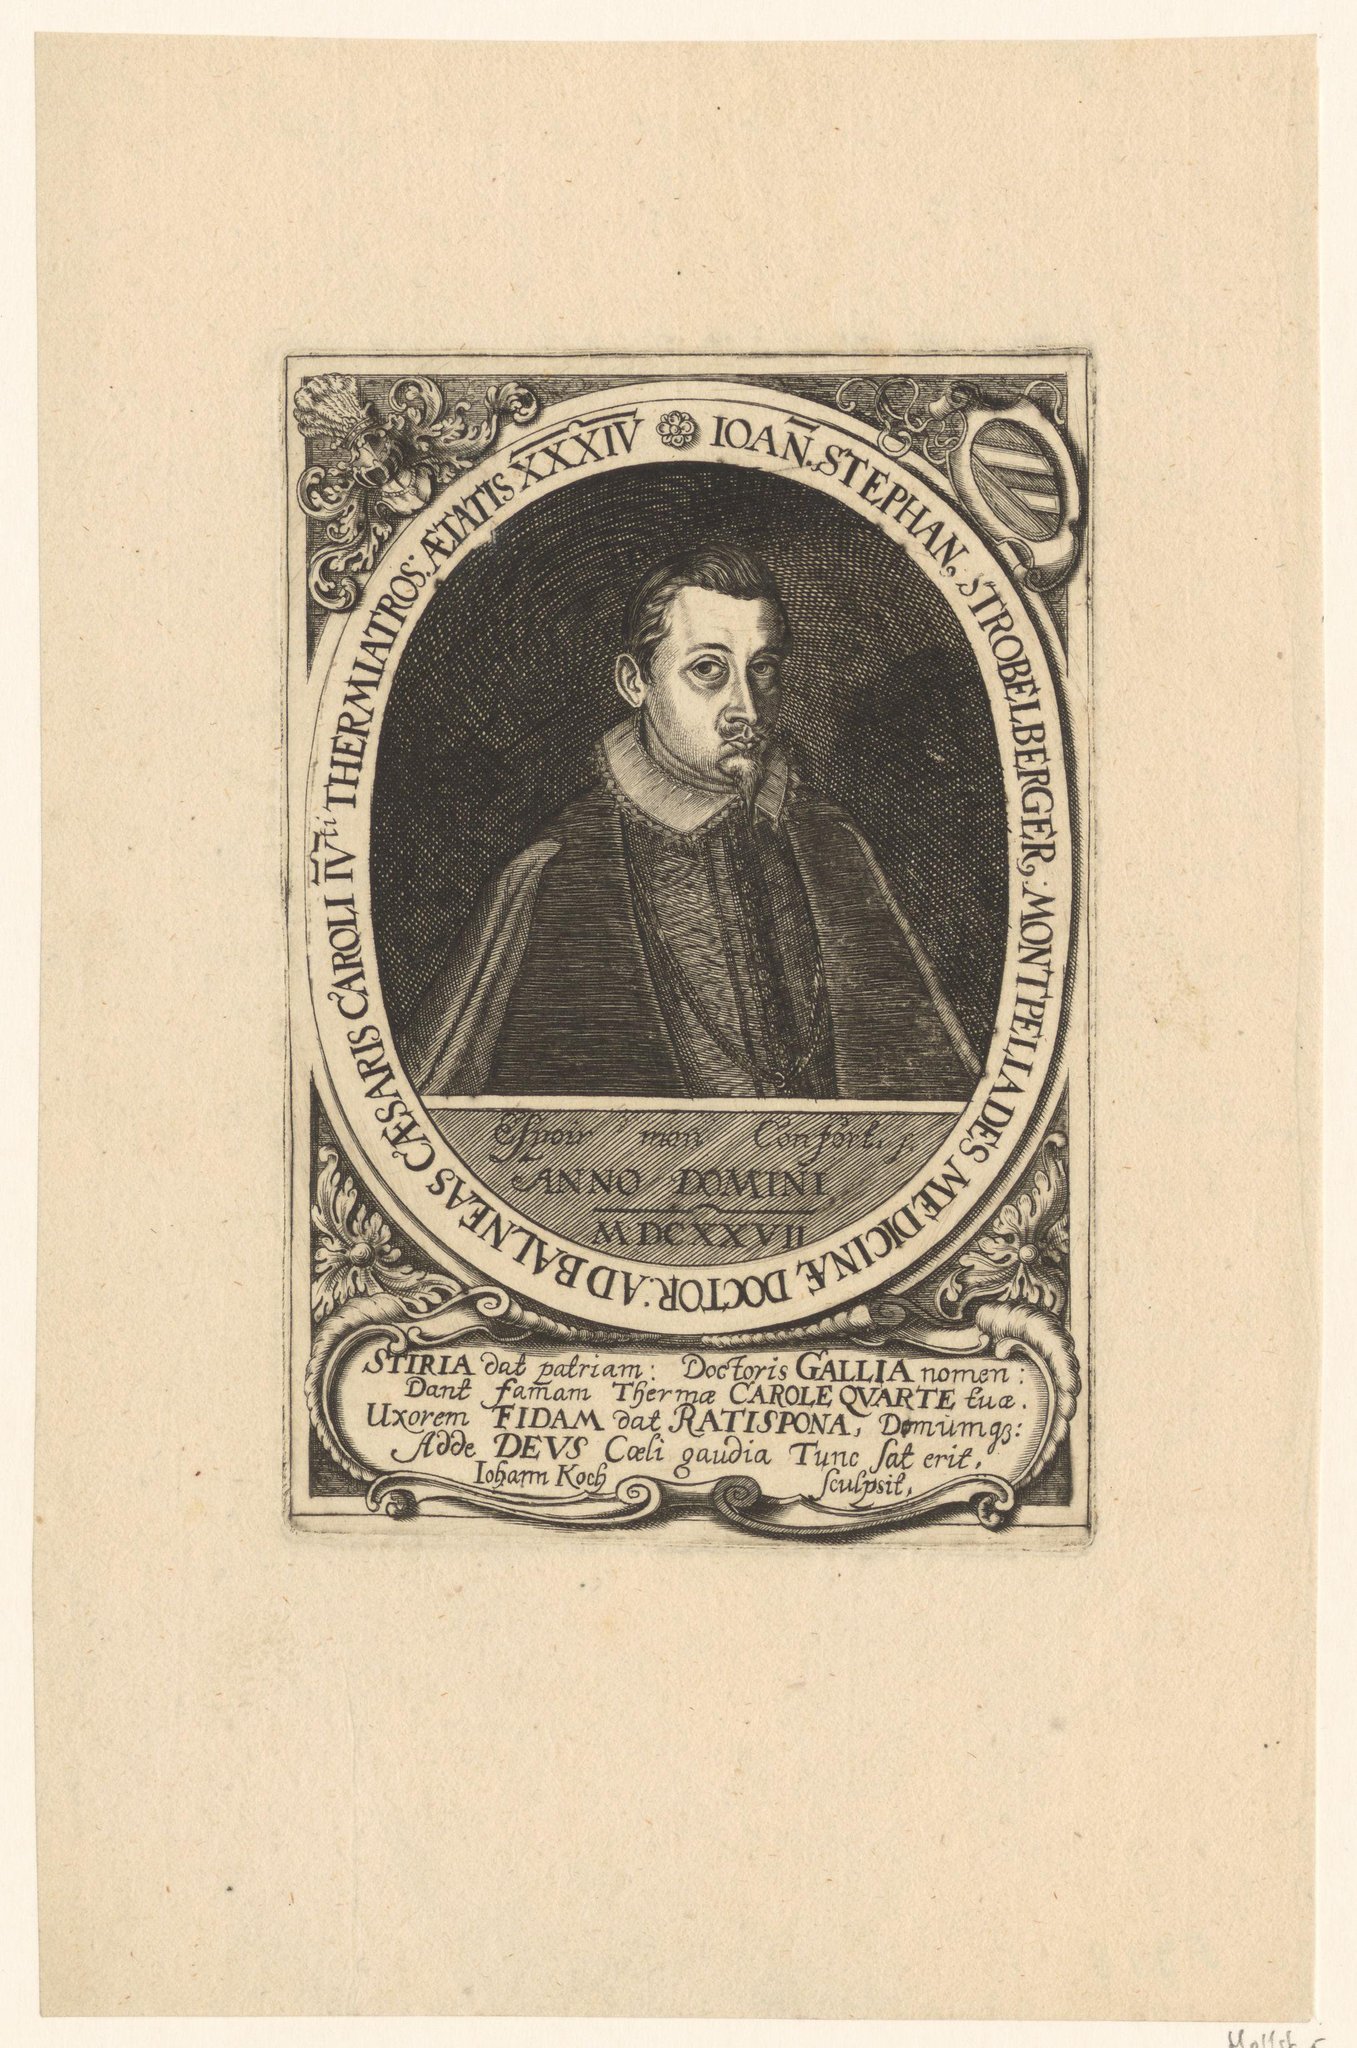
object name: print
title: Portret van Johann Stephan Strobelberger op 34-jarige leeftijd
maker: johann koch (graveur)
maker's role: print maker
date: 1627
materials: paper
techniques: engraving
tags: historical persons, physician, doctor (+ portrait of scholar, scientist)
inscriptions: collector's mark: Lugt 2228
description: Tekst in het Latijn in de omlijsting en in de ondermarge.